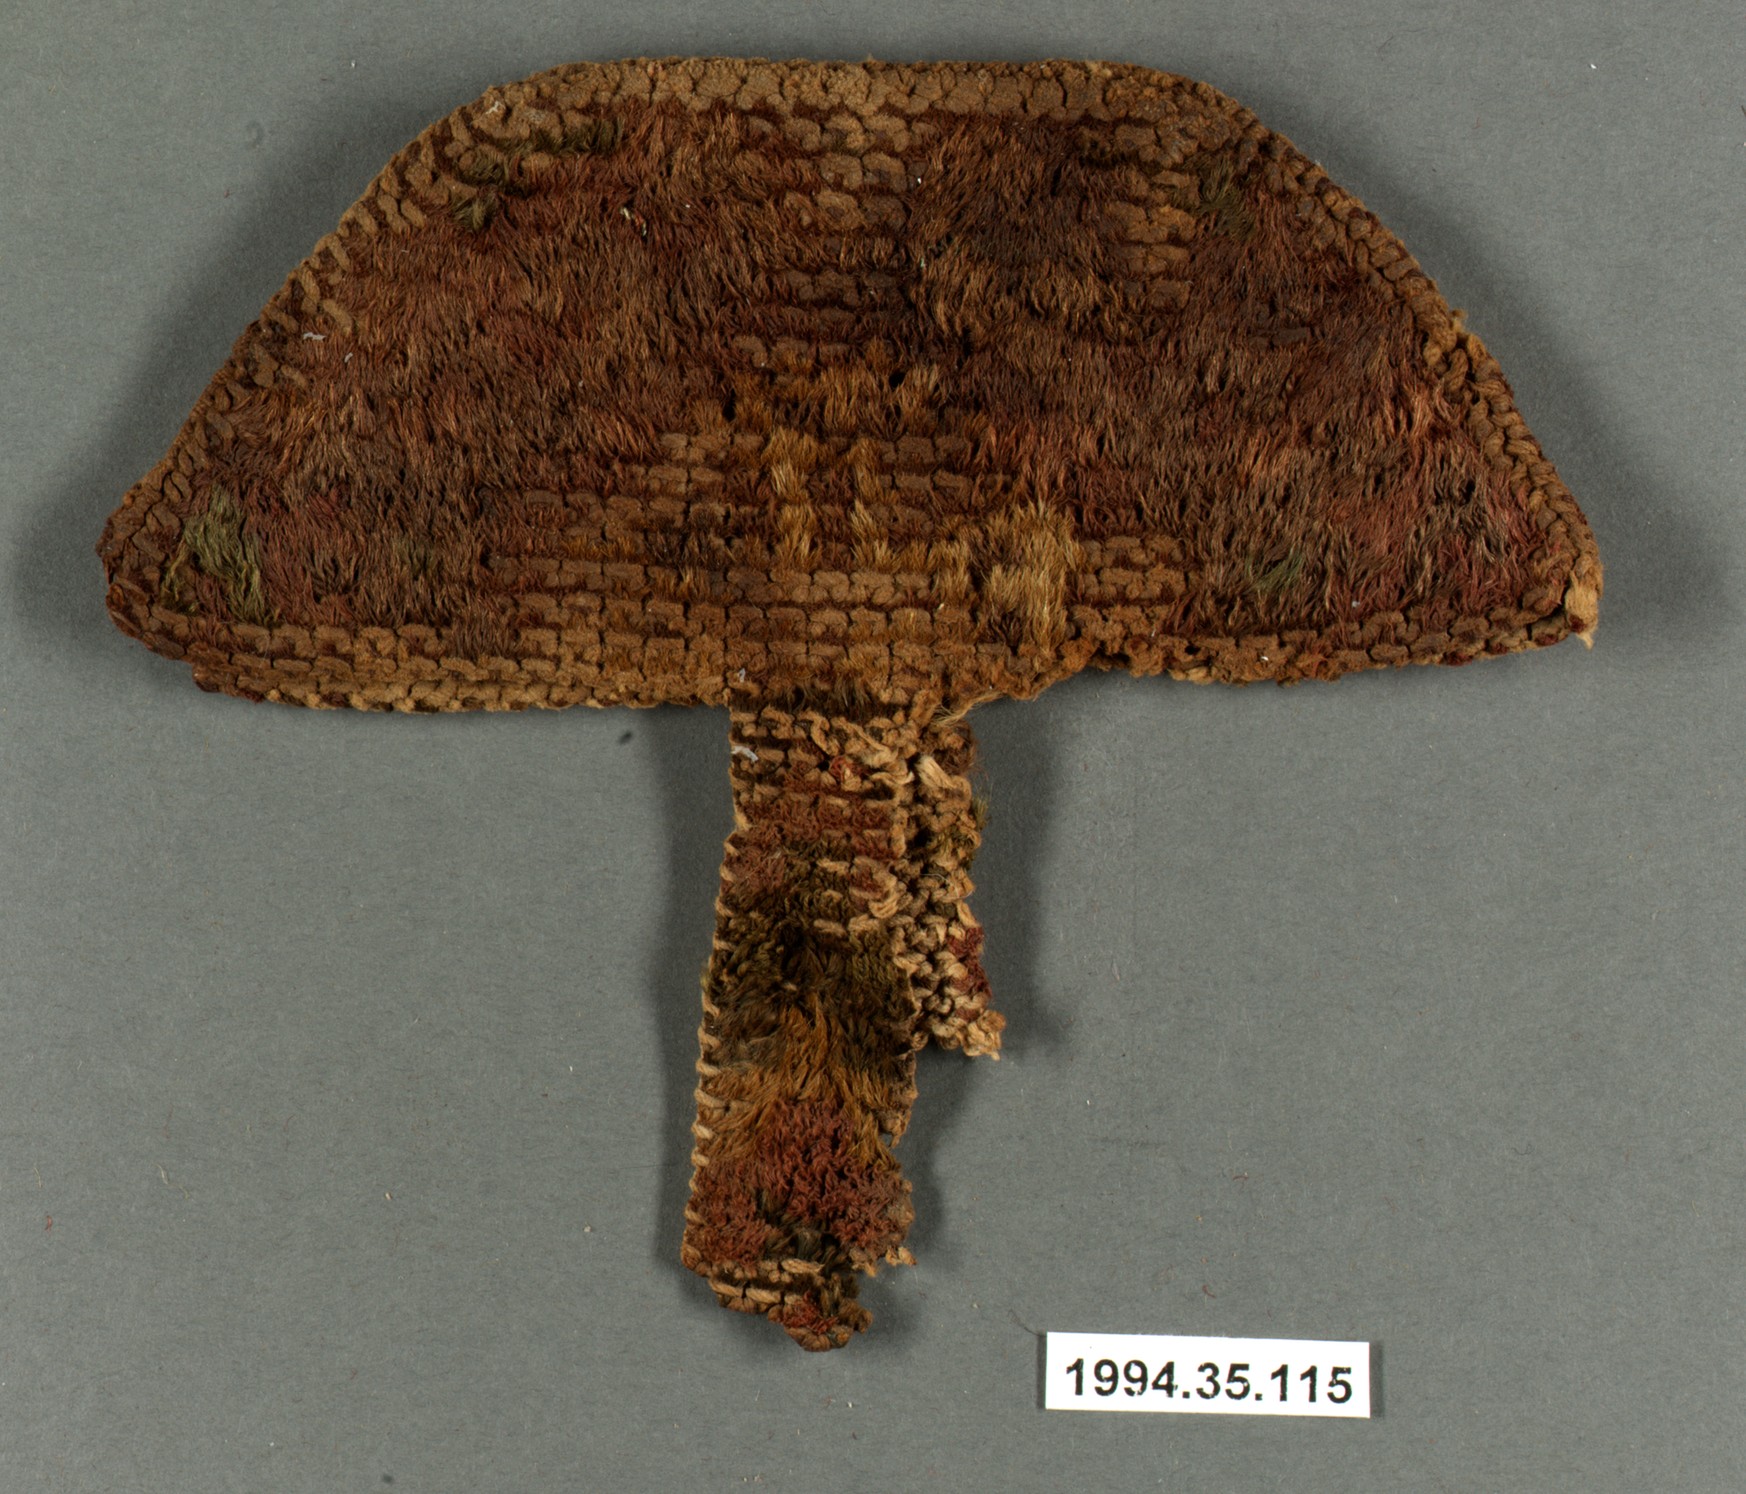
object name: hat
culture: peruvian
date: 601-1000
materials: animal fiber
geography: peru